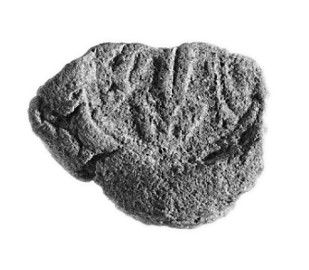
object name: sealing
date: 1981-1640 BCE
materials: clay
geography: egypt